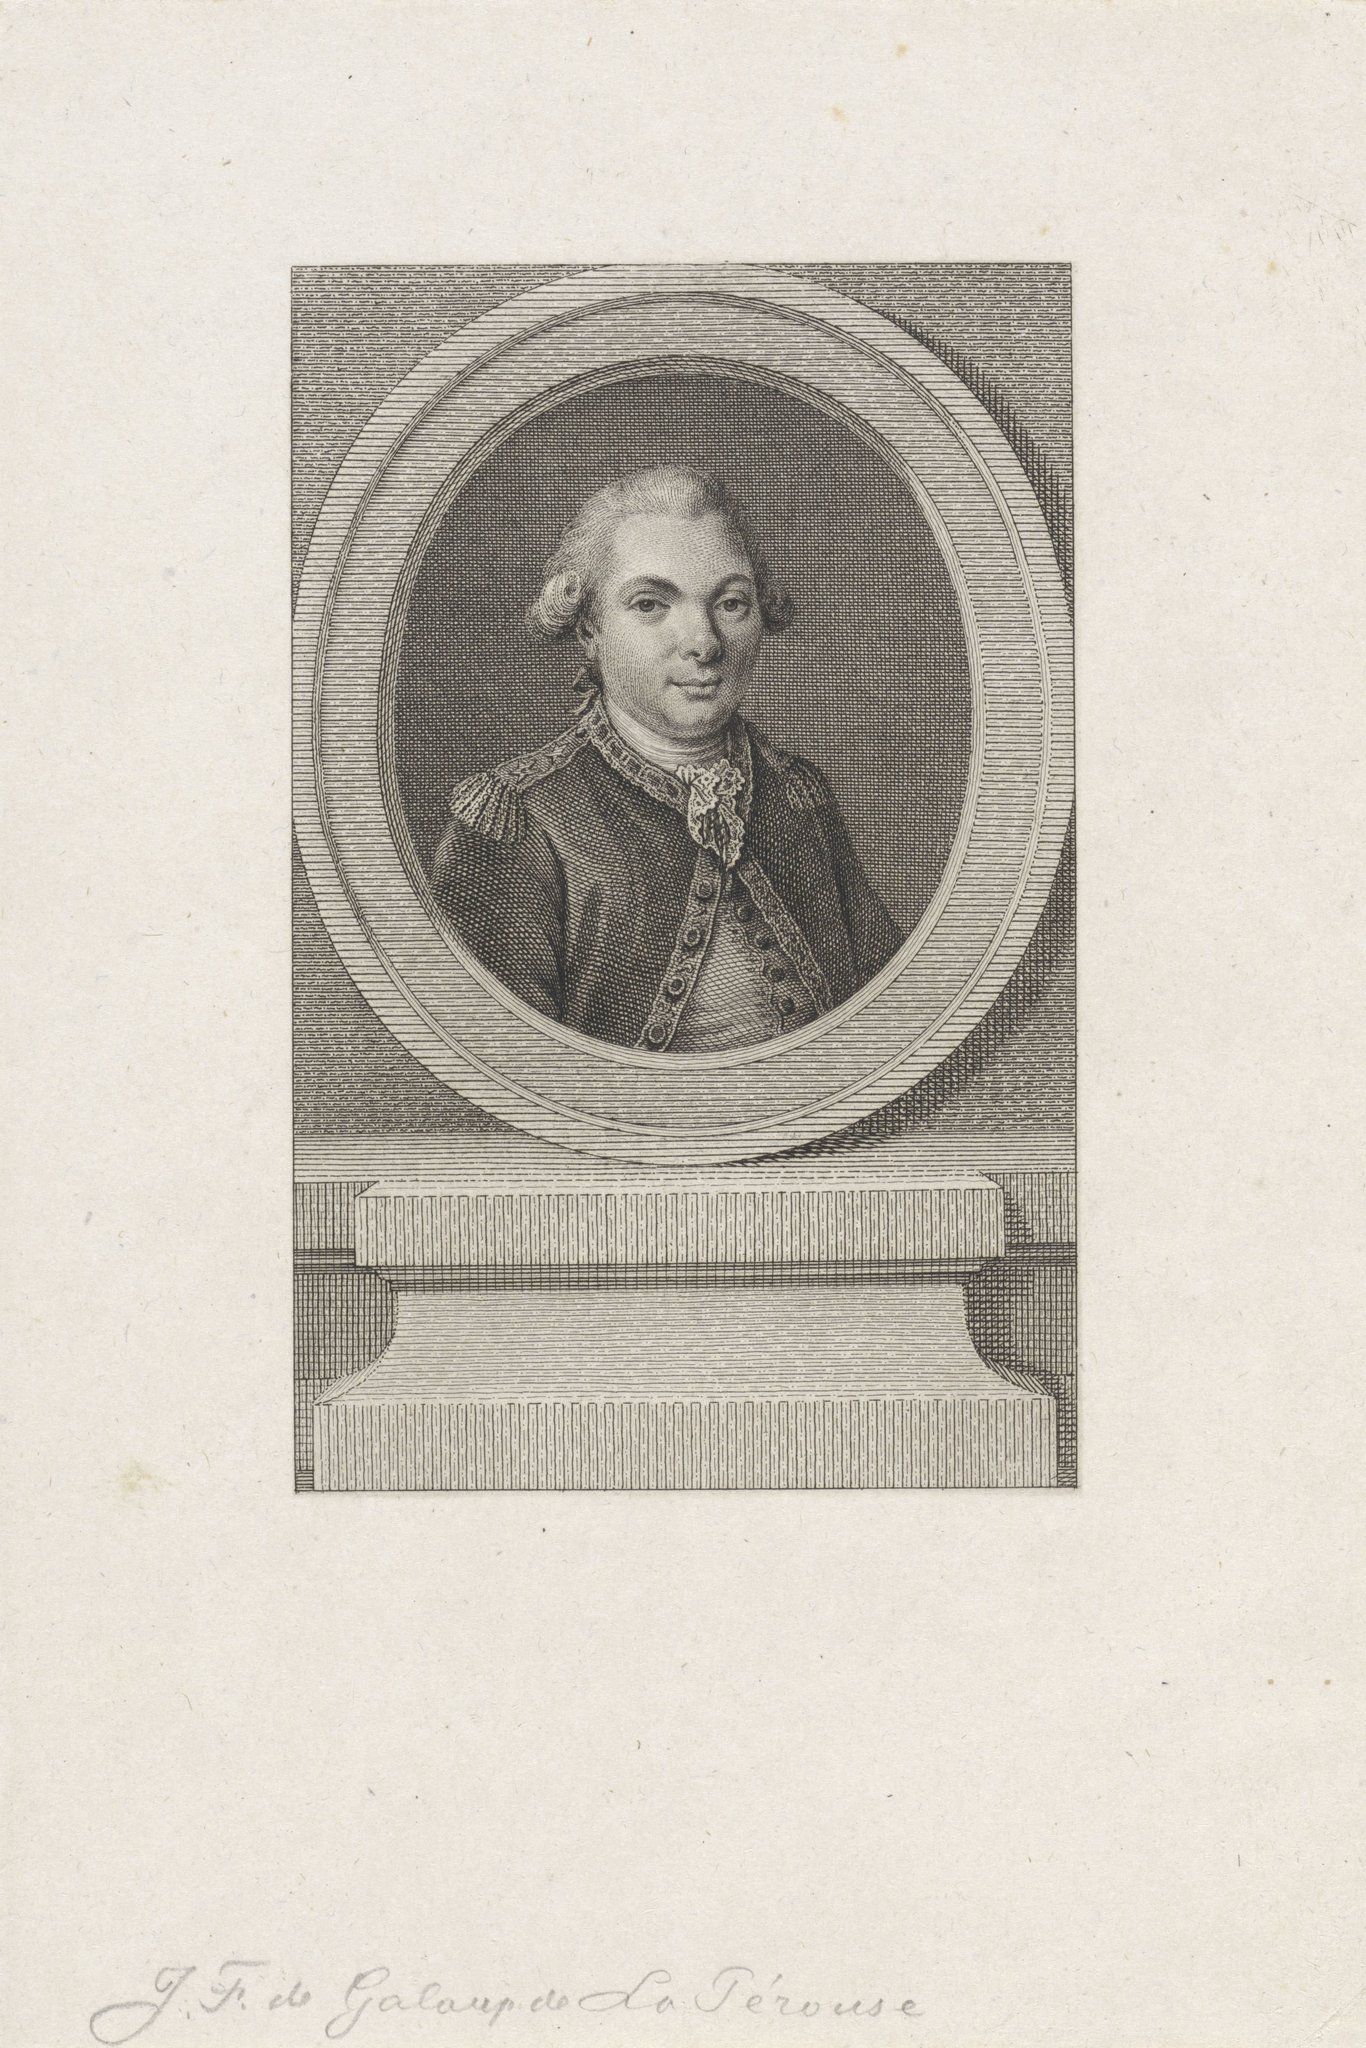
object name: print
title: Portret van Jean-François de La Pérouse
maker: reinier vinkeles (i)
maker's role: draughtsman, print maker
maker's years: 1741-1816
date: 1785-1816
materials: paper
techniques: engraving, etching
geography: amsterdam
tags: officier, jean-françois de la pérouse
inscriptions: collector's mark: Lugt 240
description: Portret van Jean-François de La Pérouse, Frans marine-officier en ontdekkingsreiziger.